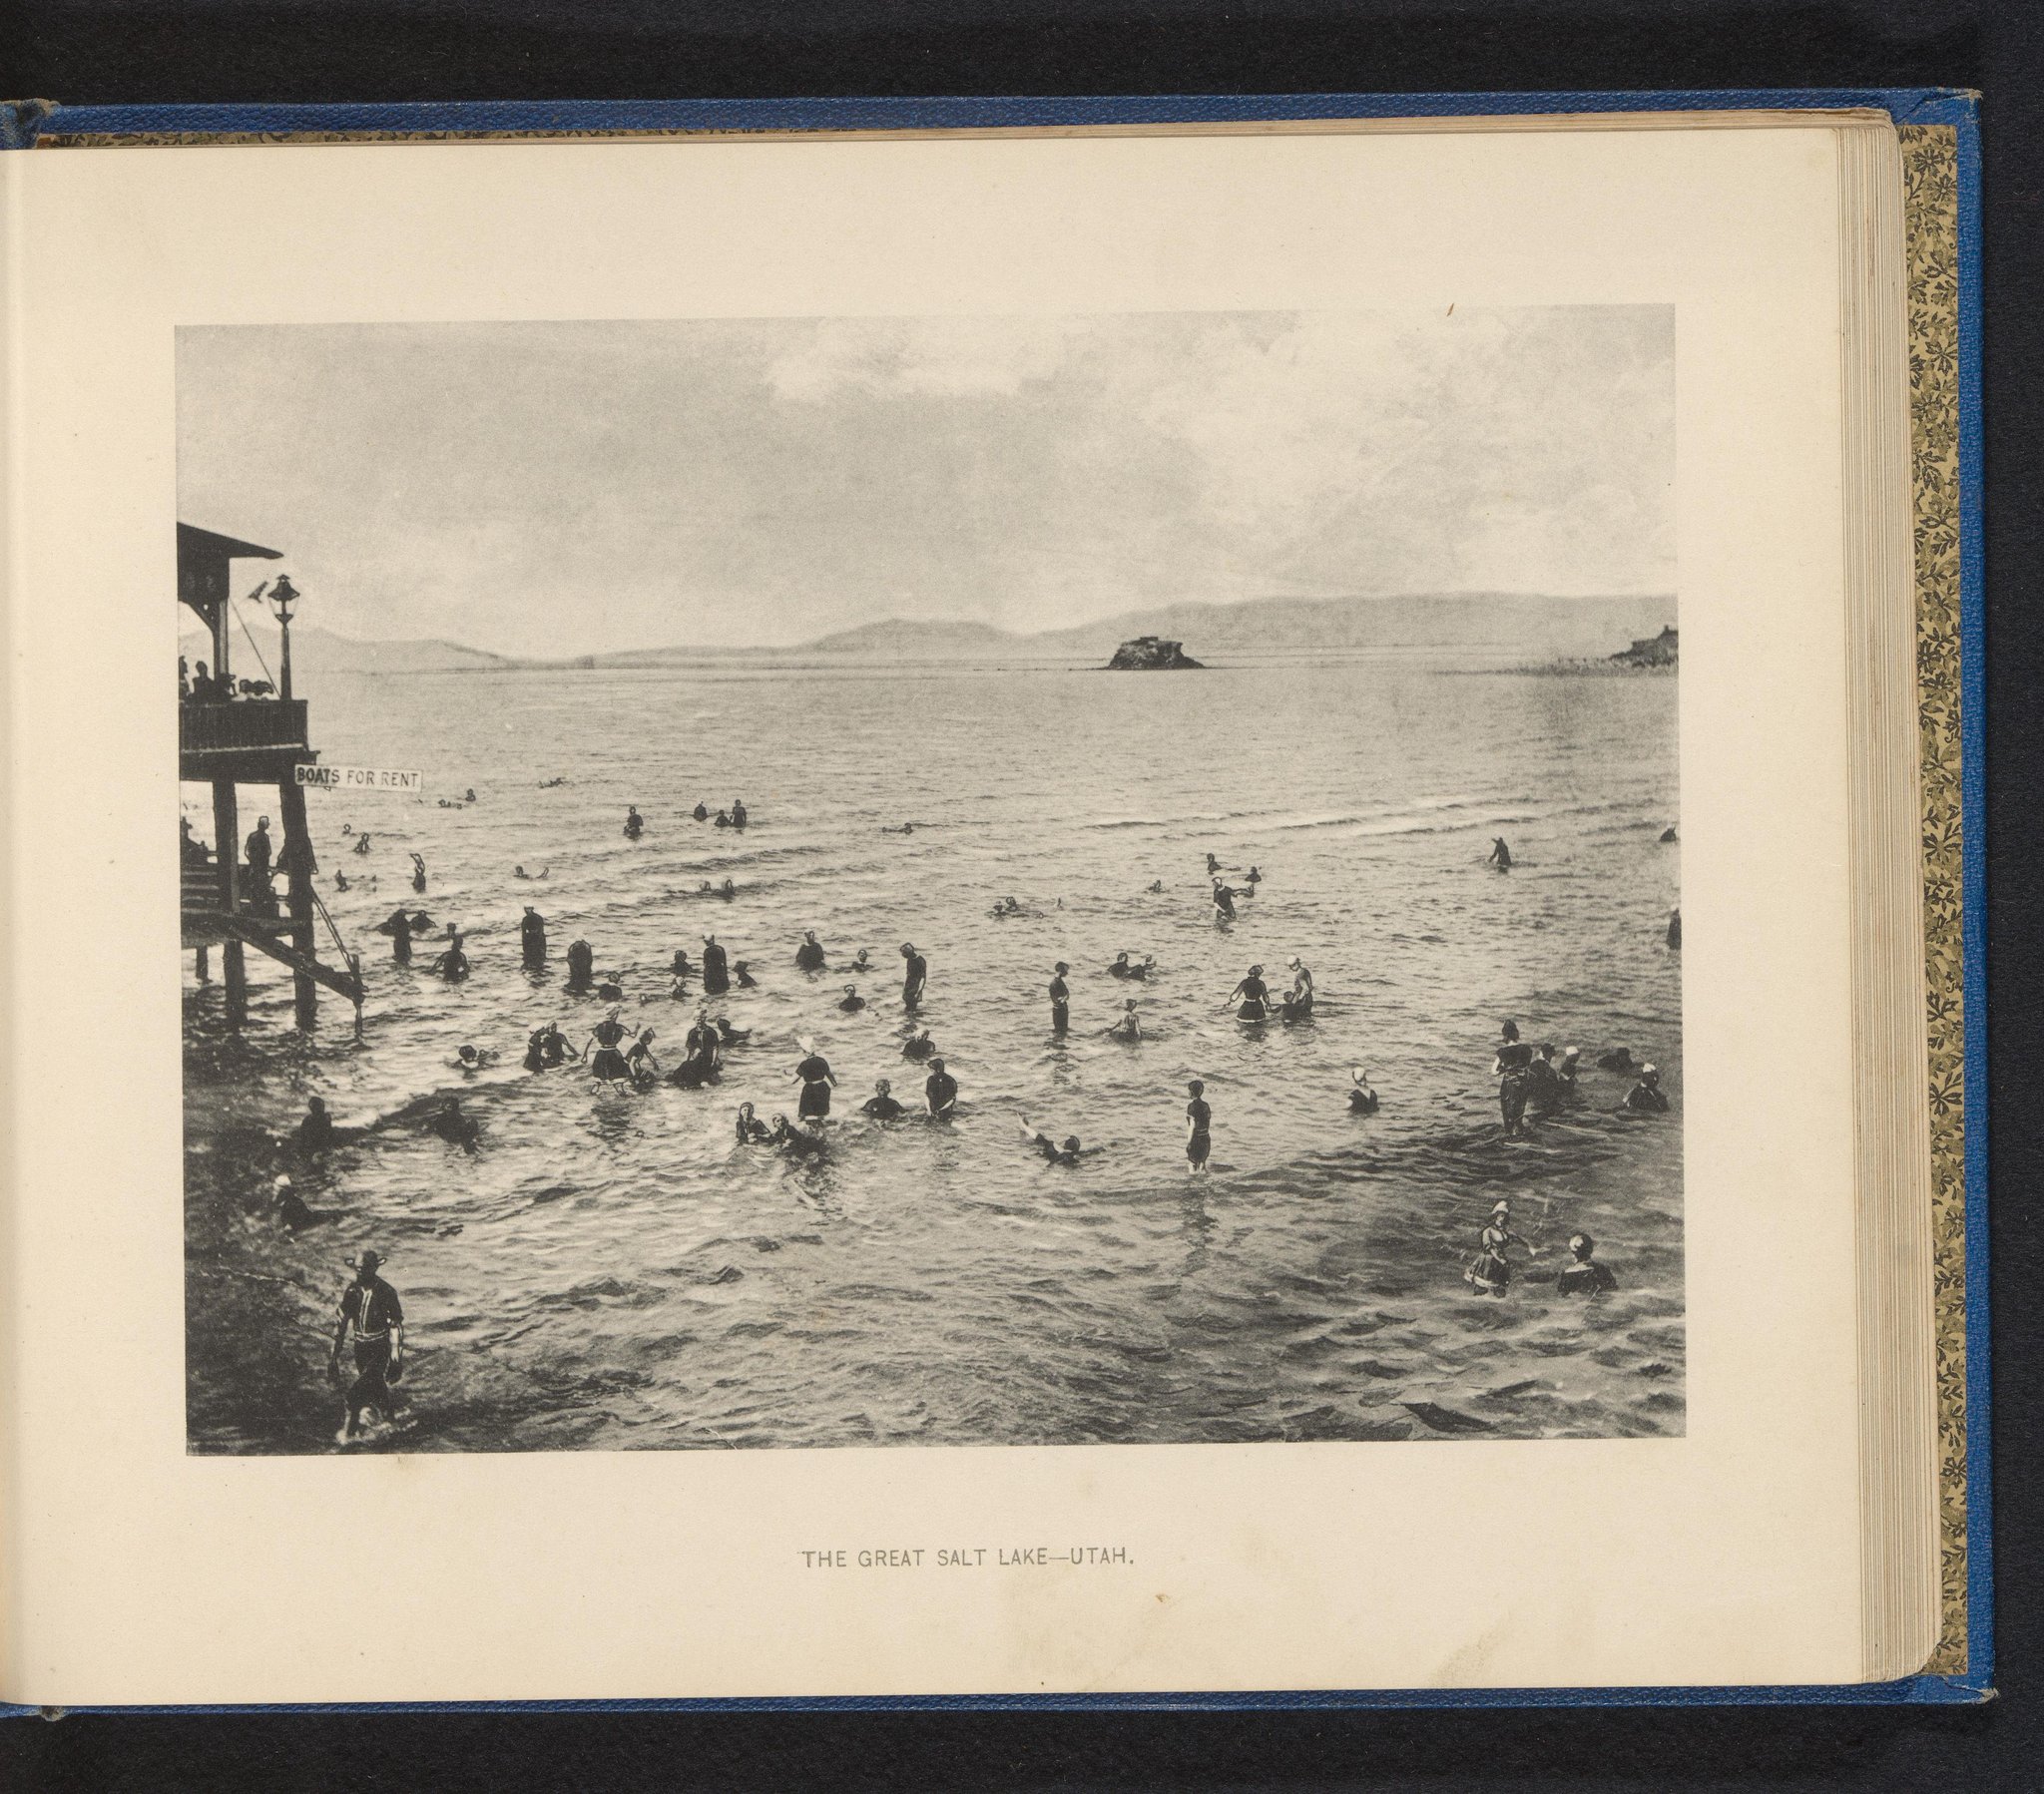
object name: page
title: Gezicht op mensen die zwemmen in het Great Salt Lake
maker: Anonymous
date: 1883-1893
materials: paper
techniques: photograph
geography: utah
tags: lake, swimming (movement in water)